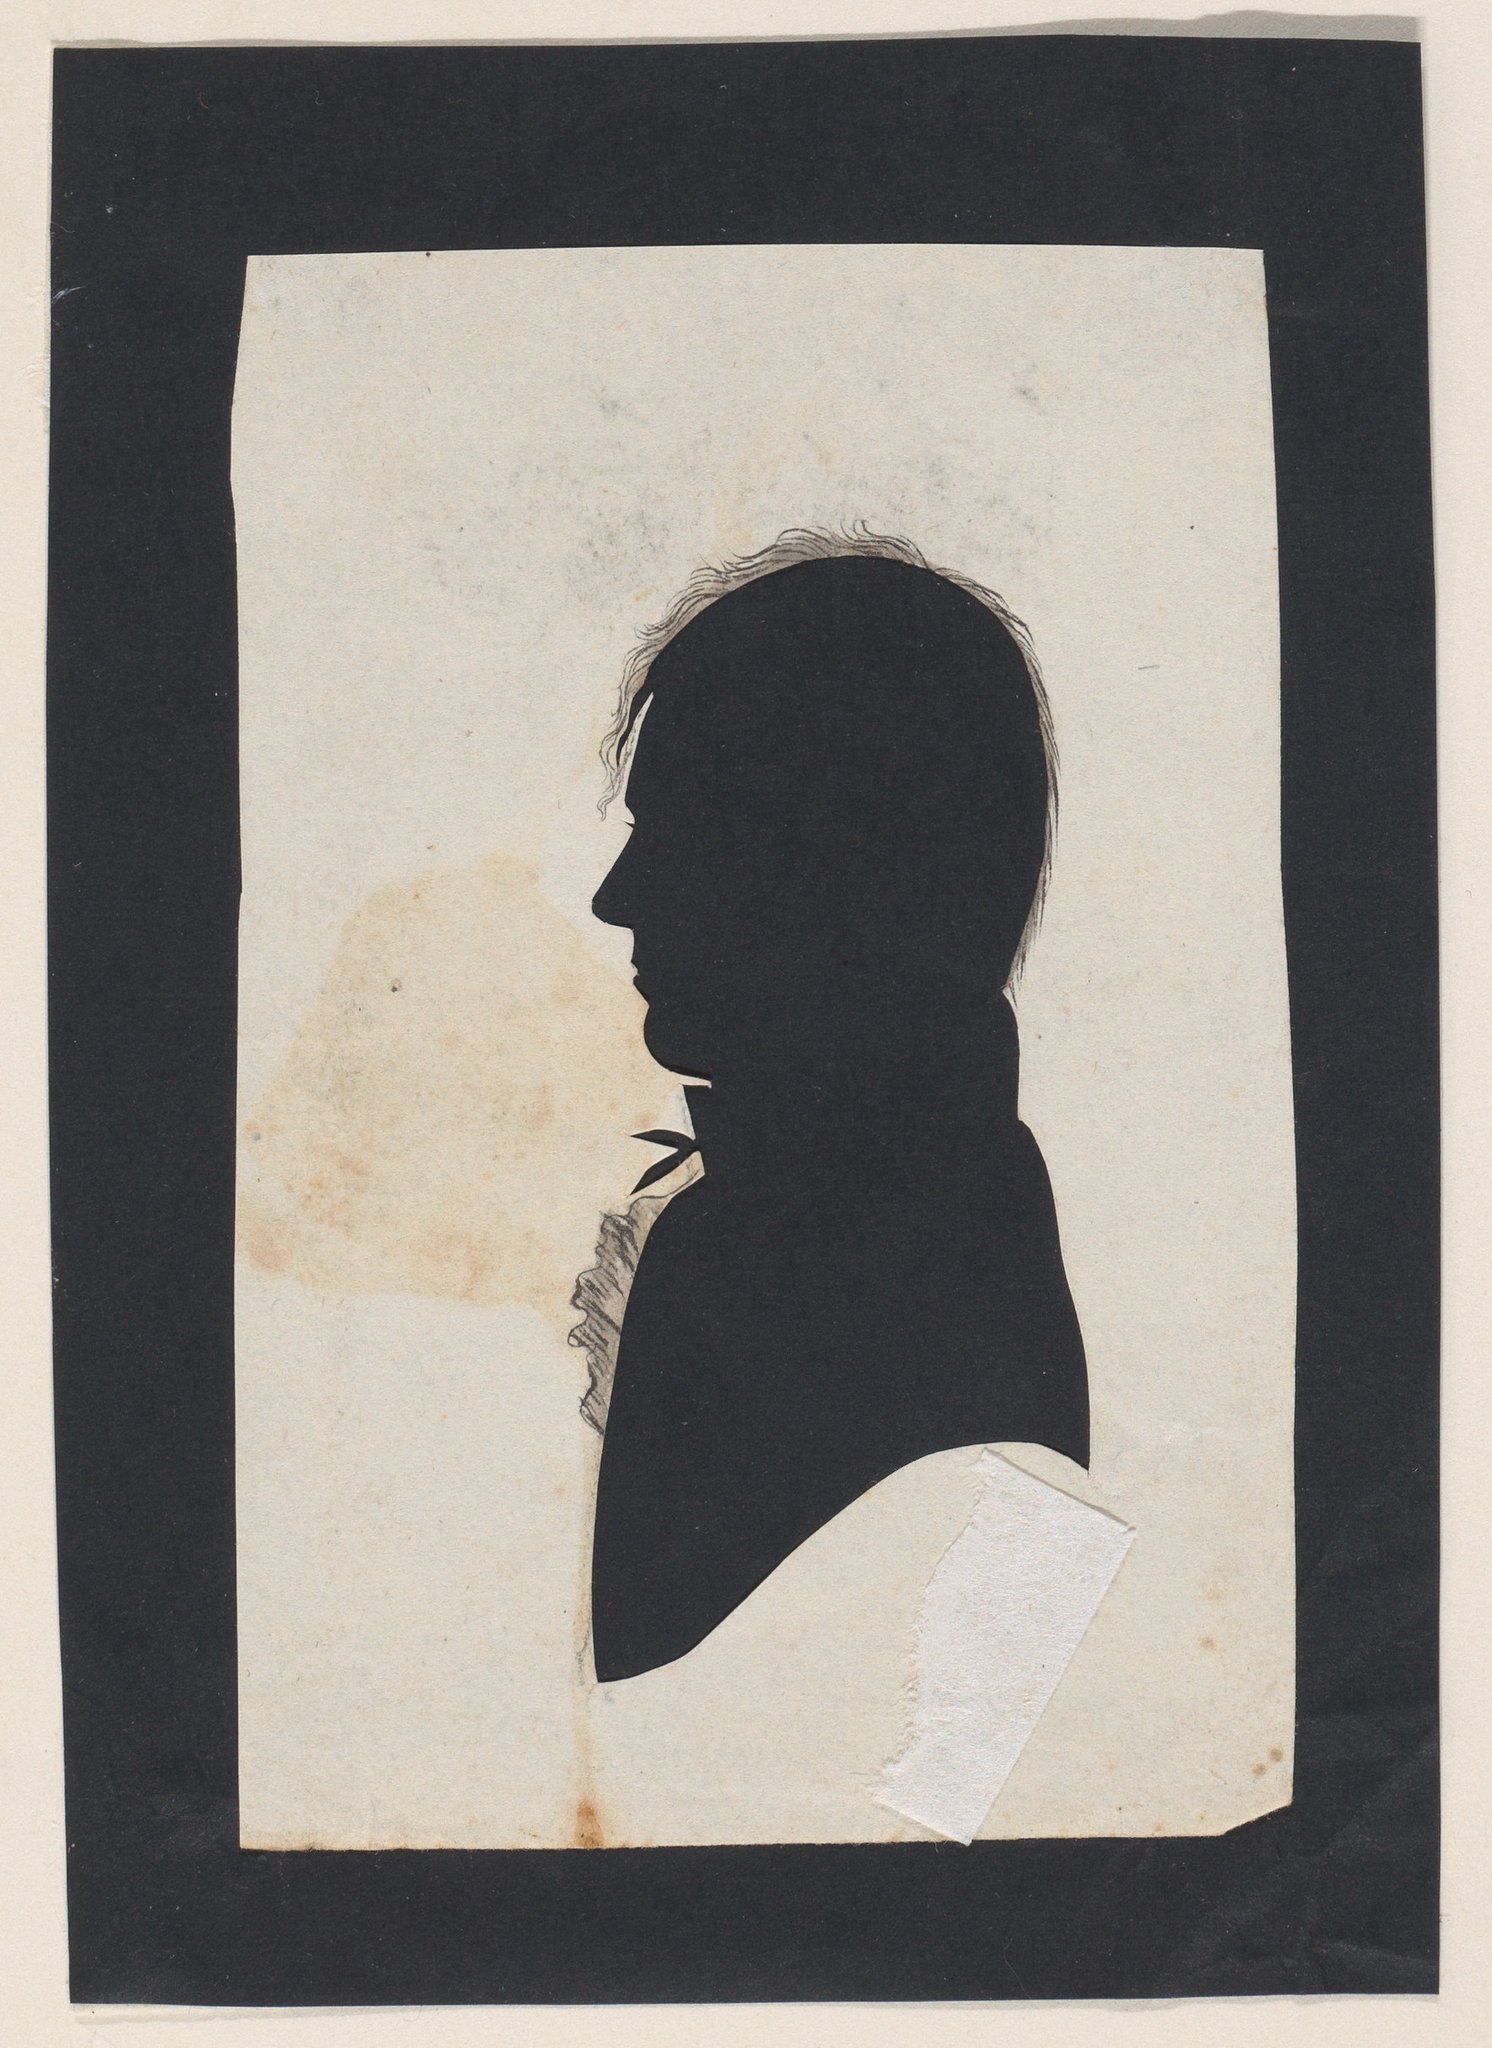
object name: cut paper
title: Silhouette of an unknown man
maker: moses chapman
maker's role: artist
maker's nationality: american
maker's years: 1783-1821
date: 1803-1821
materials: ink, paper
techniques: cutting, pen